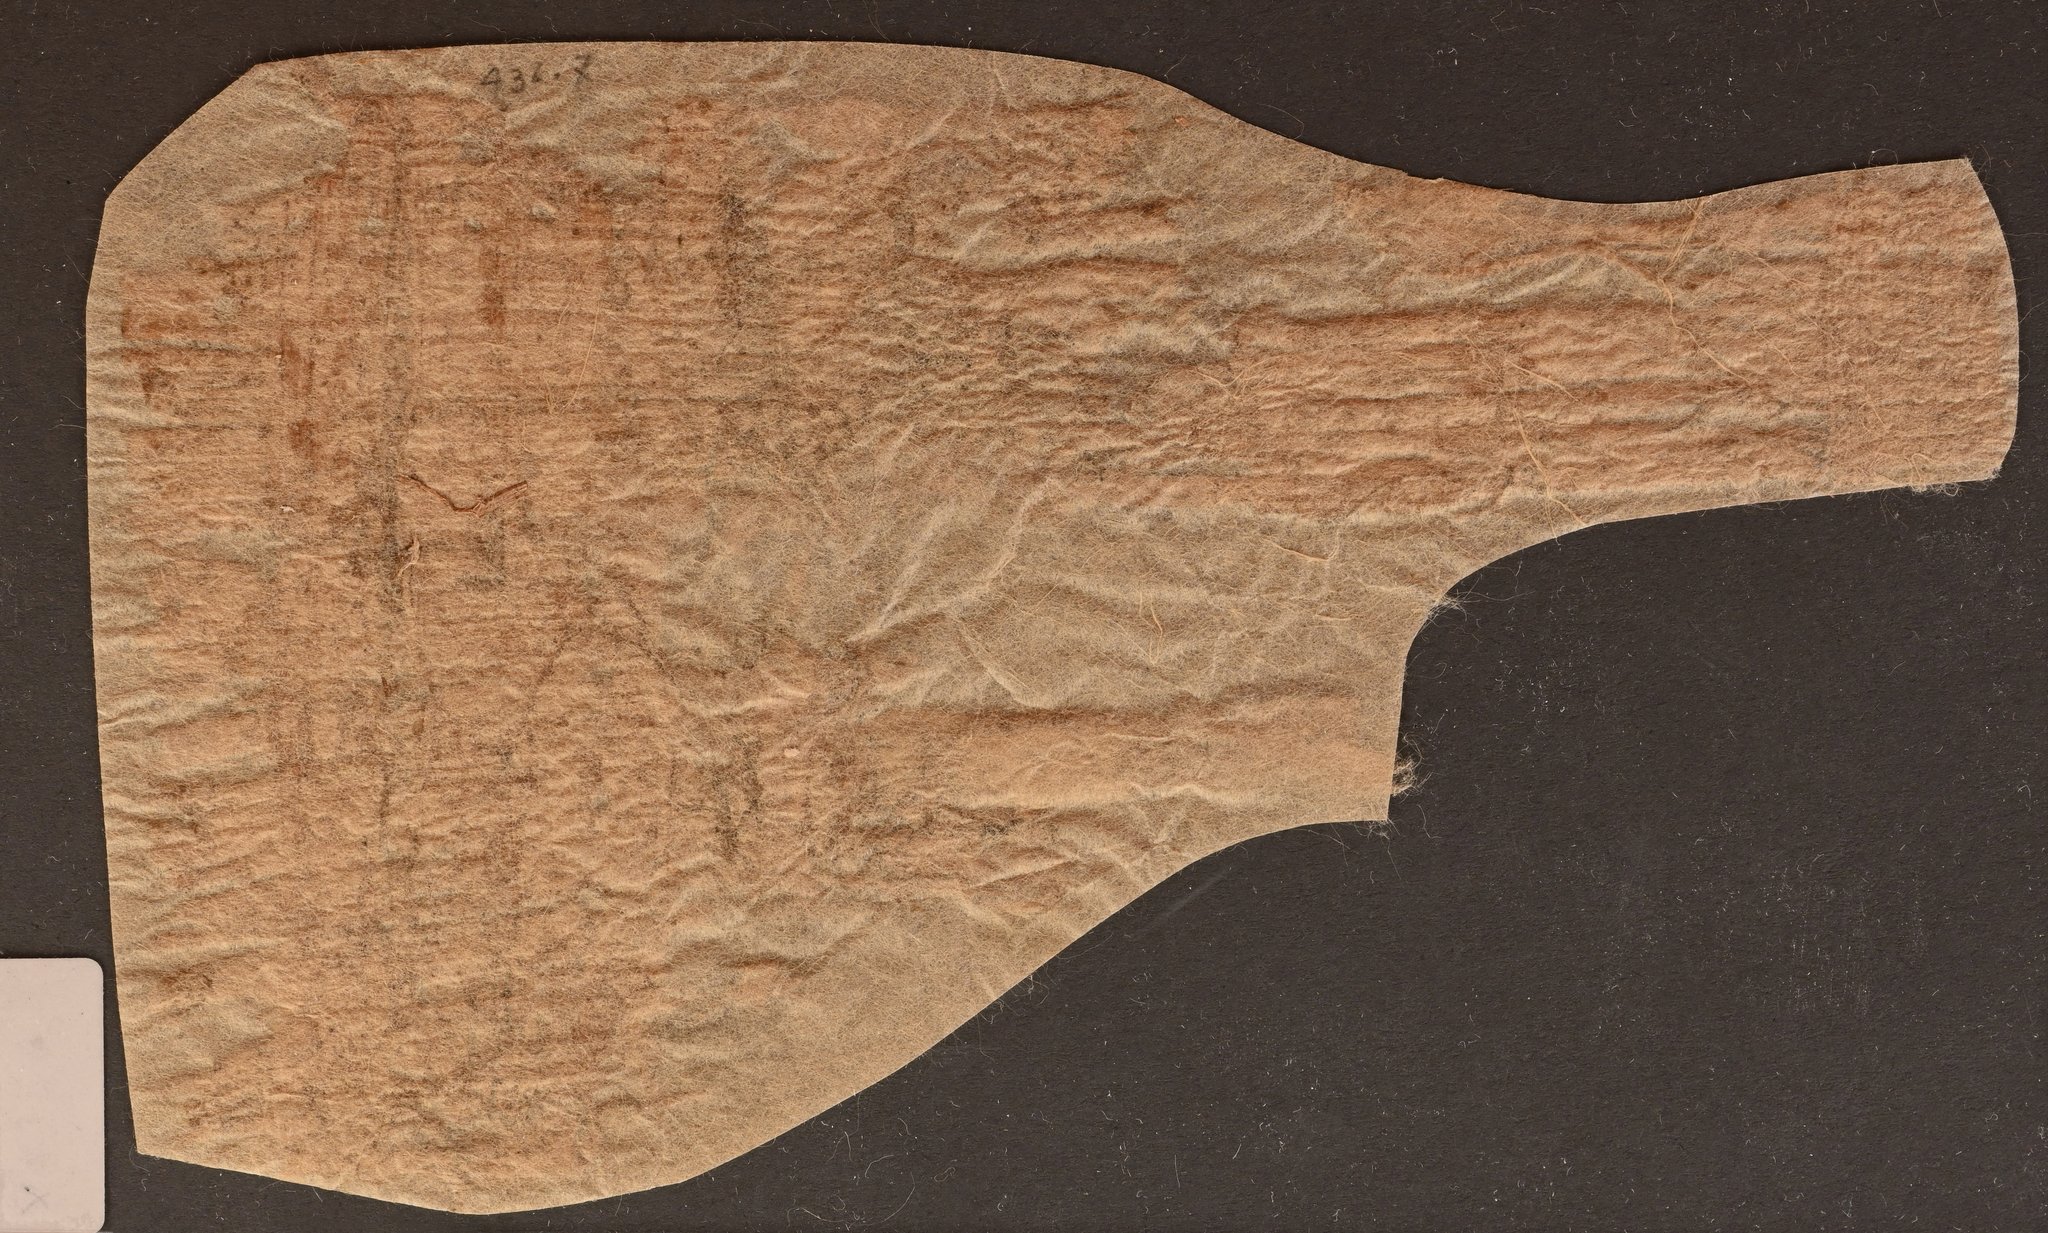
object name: fragment of a non illustrated single work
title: Papyrus Fragments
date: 701-1000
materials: ink, papyrus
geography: egypt